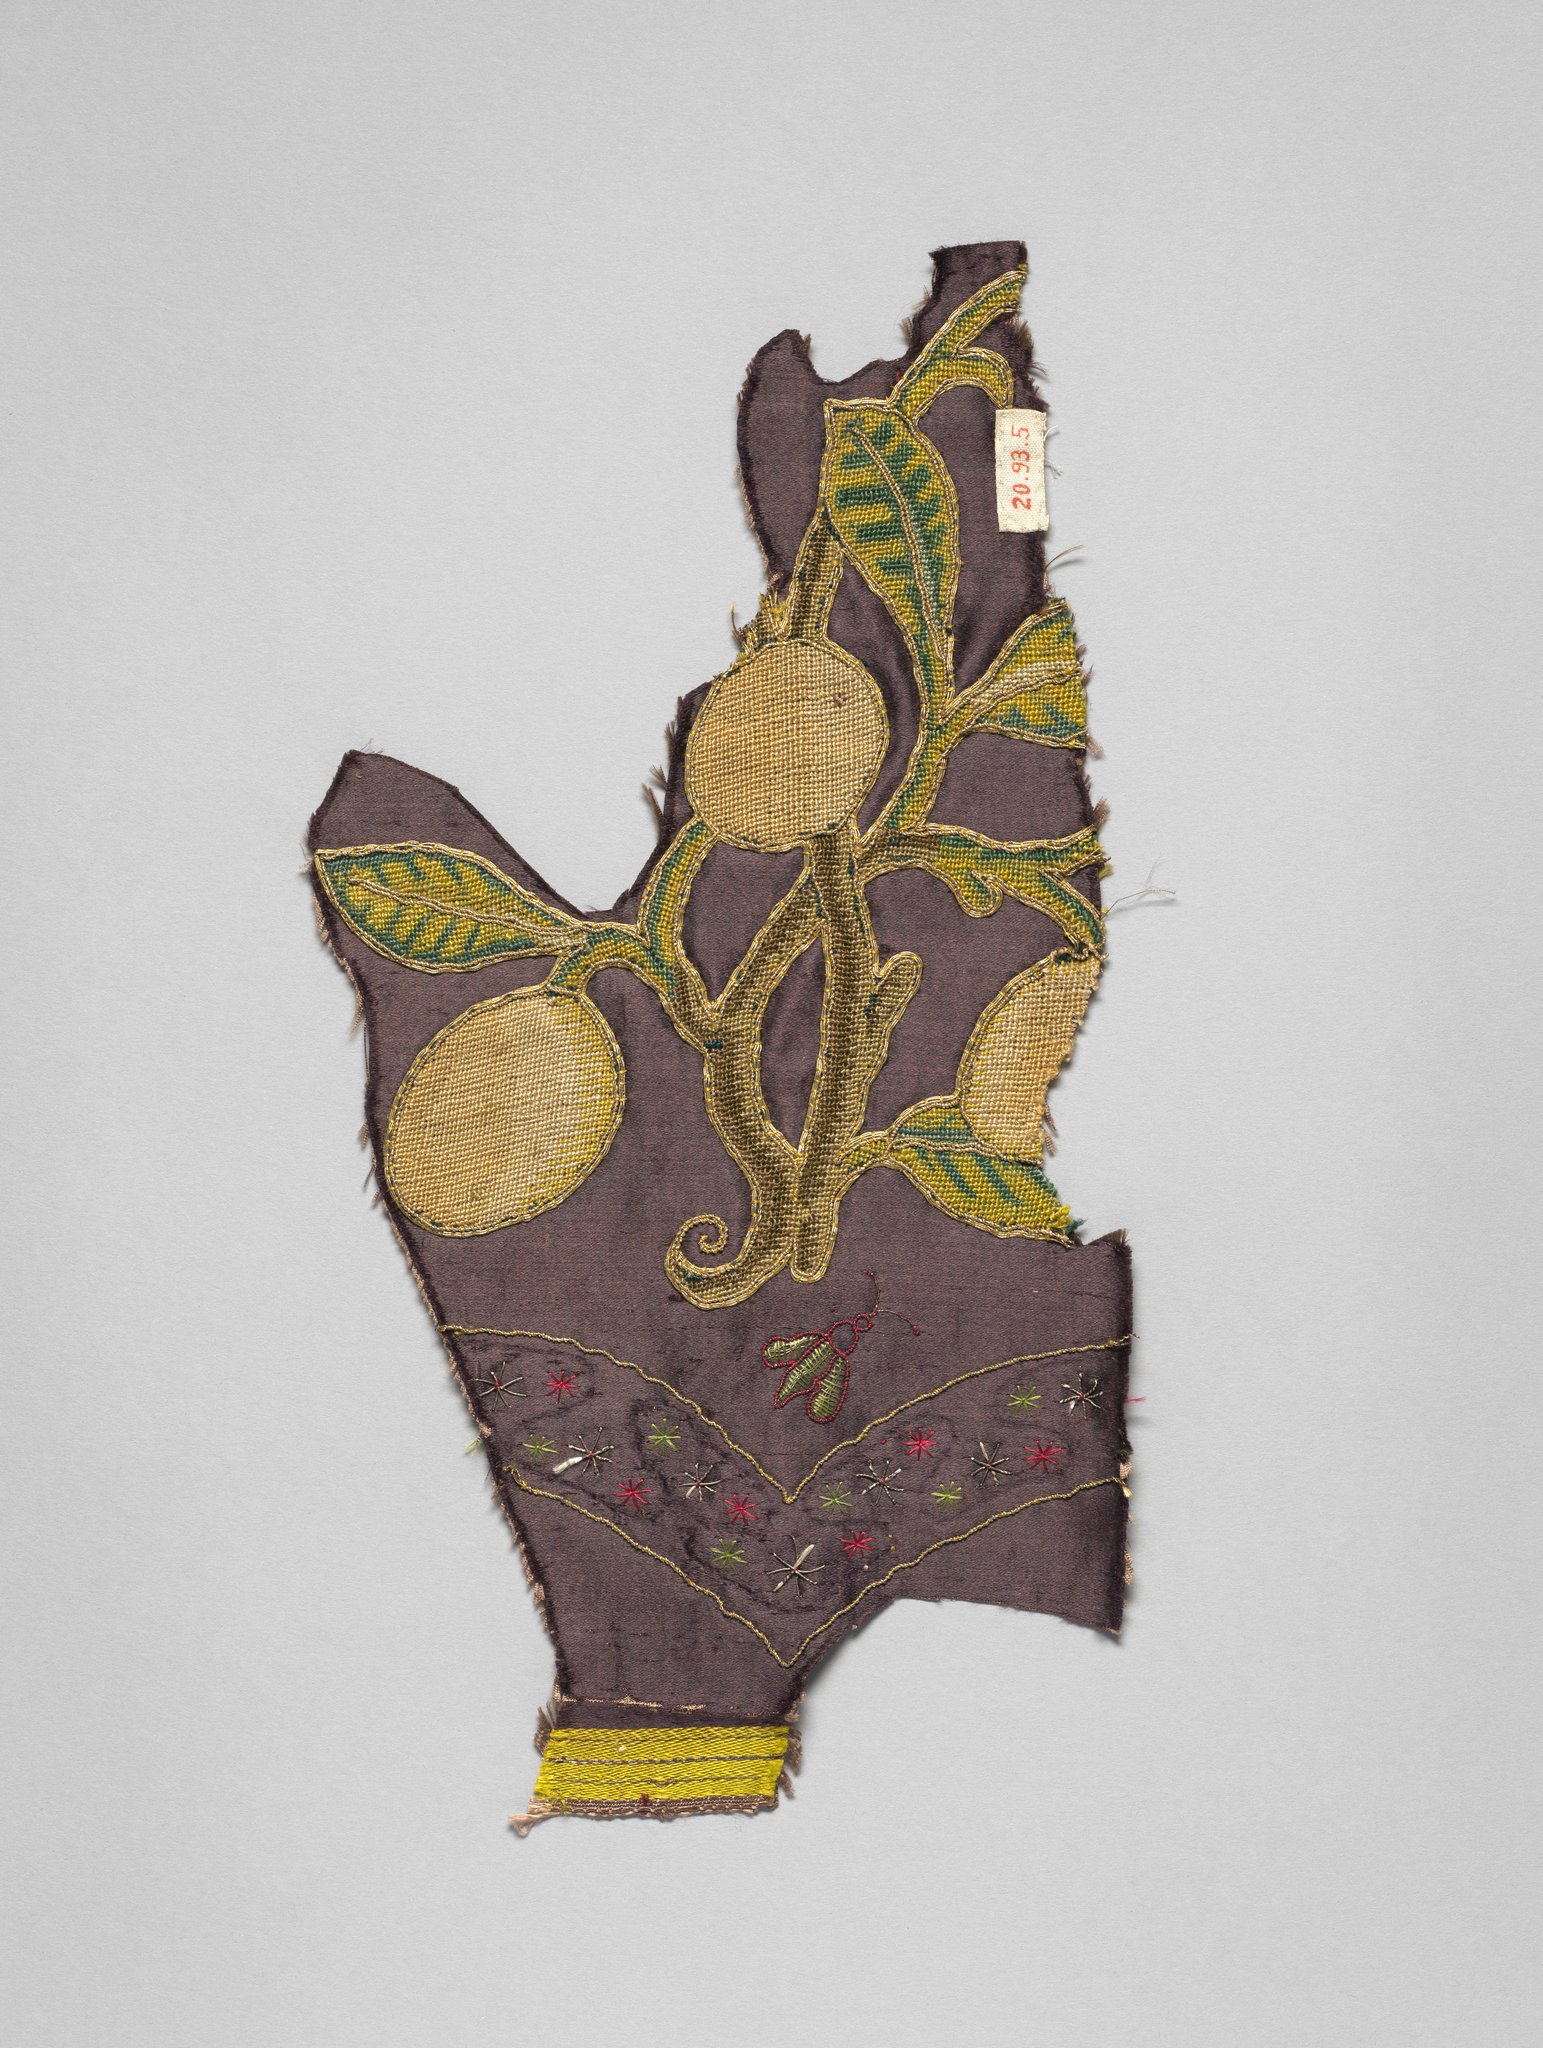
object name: piece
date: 1567-1600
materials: metal thread, textile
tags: fruit